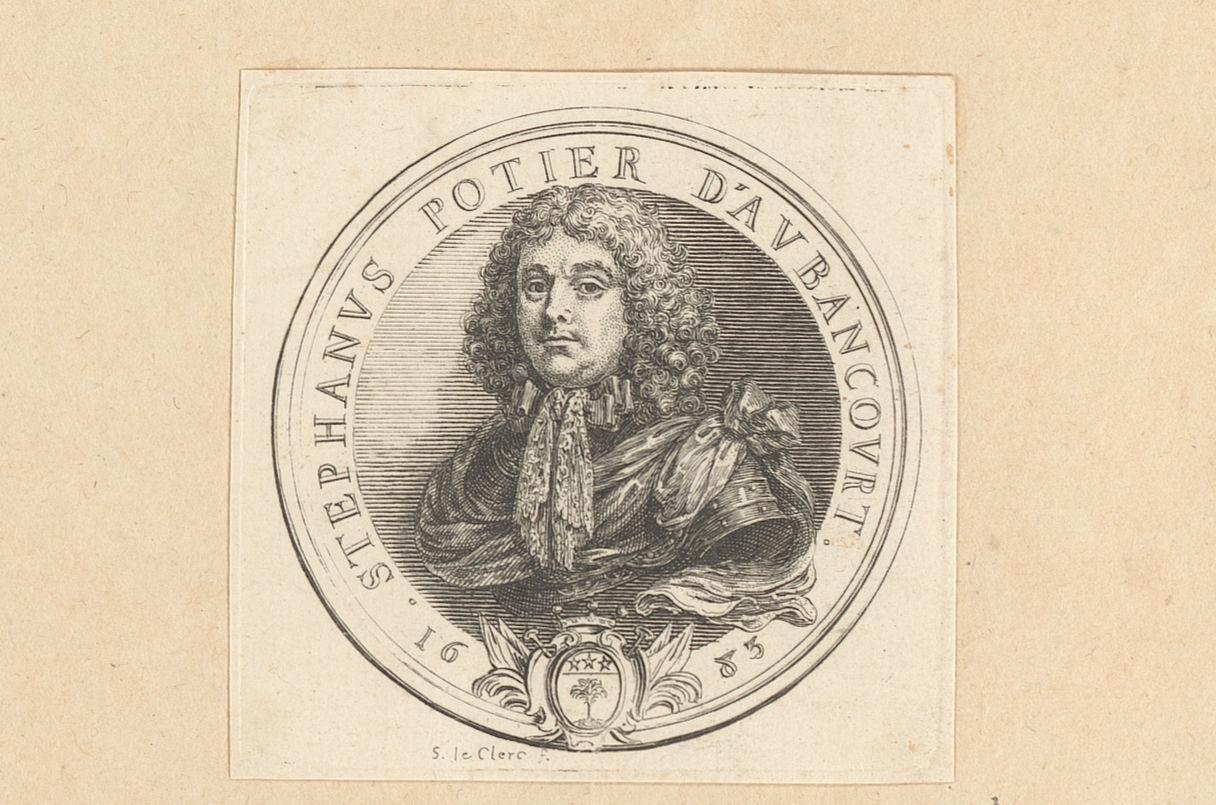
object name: album leaf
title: Medaille met het portret van Etienne Pottier d'Aubancourt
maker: sébastien leclerc (i)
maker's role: print maker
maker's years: 1637-1714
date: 1683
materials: paper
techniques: etching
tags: historical persons, medal (considered as a piece of sculpture, regardless of its specific function)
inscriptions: date